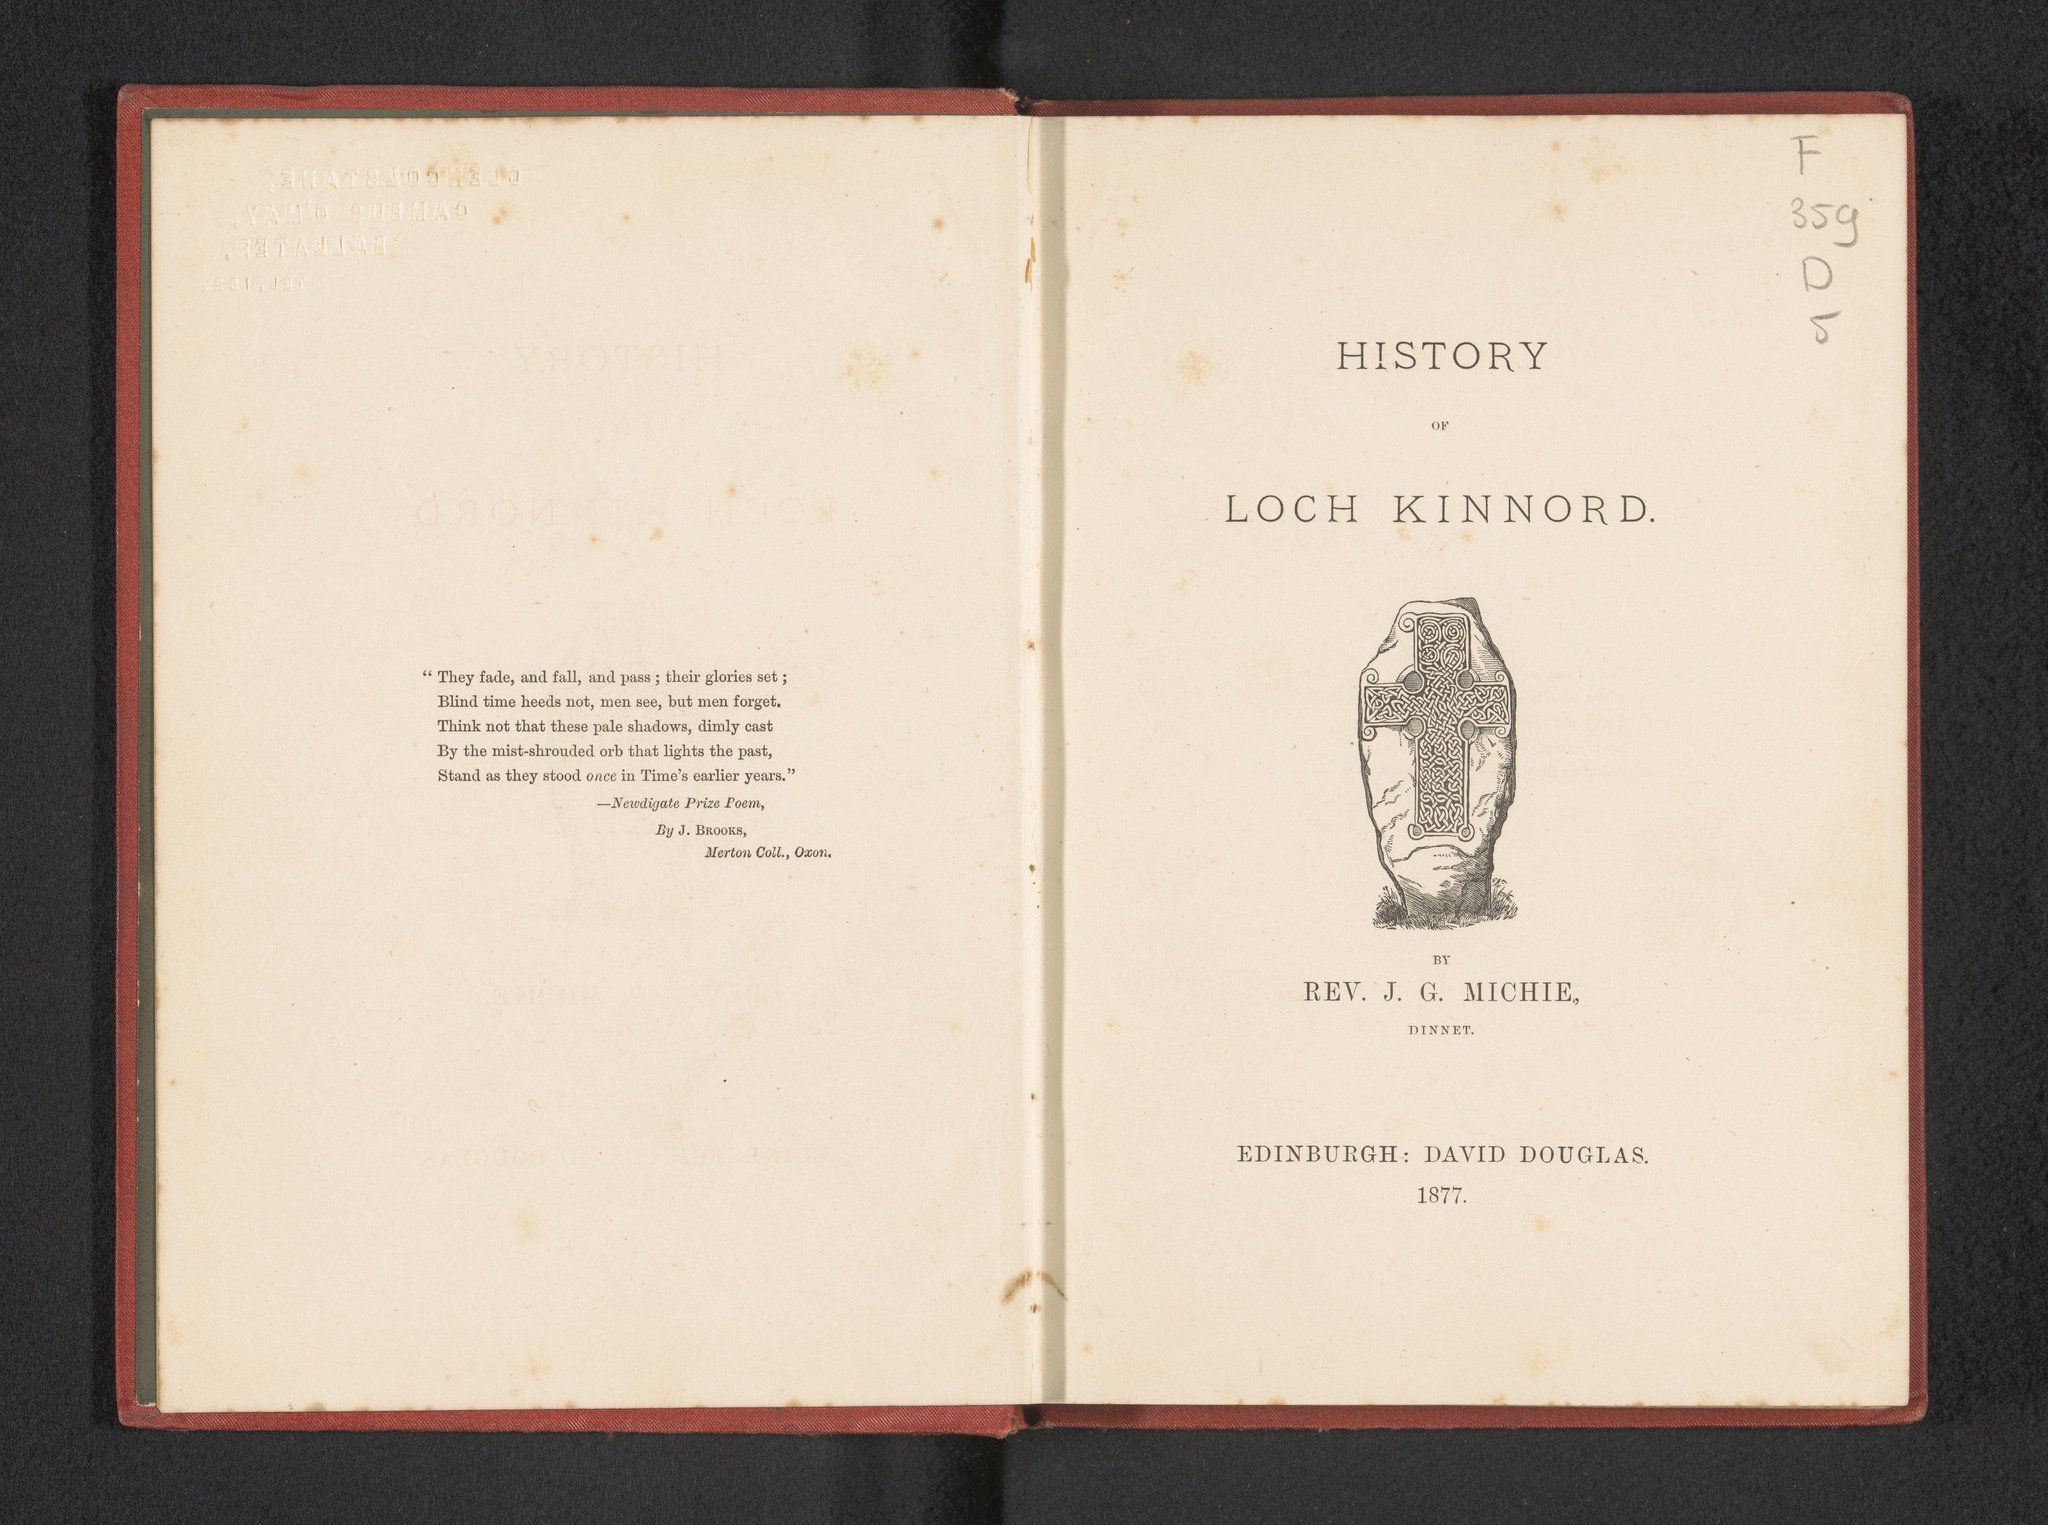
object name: book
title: History of Loch Kinnord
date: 1877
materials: linen, paper, photographic support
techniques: albumen print, printing, engraving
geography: edinburgh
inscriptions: annotation: ‘2 monumental photos/ by George Washington Wilson’, inscription: ‘Glencolstane, Cambus o'May, Ballater. Tel.132.’, annotation: ‘2 tipped in photographs’, inscription: ‘Glencolstane, Cambus o'May, Ballater. Tel. 132.’